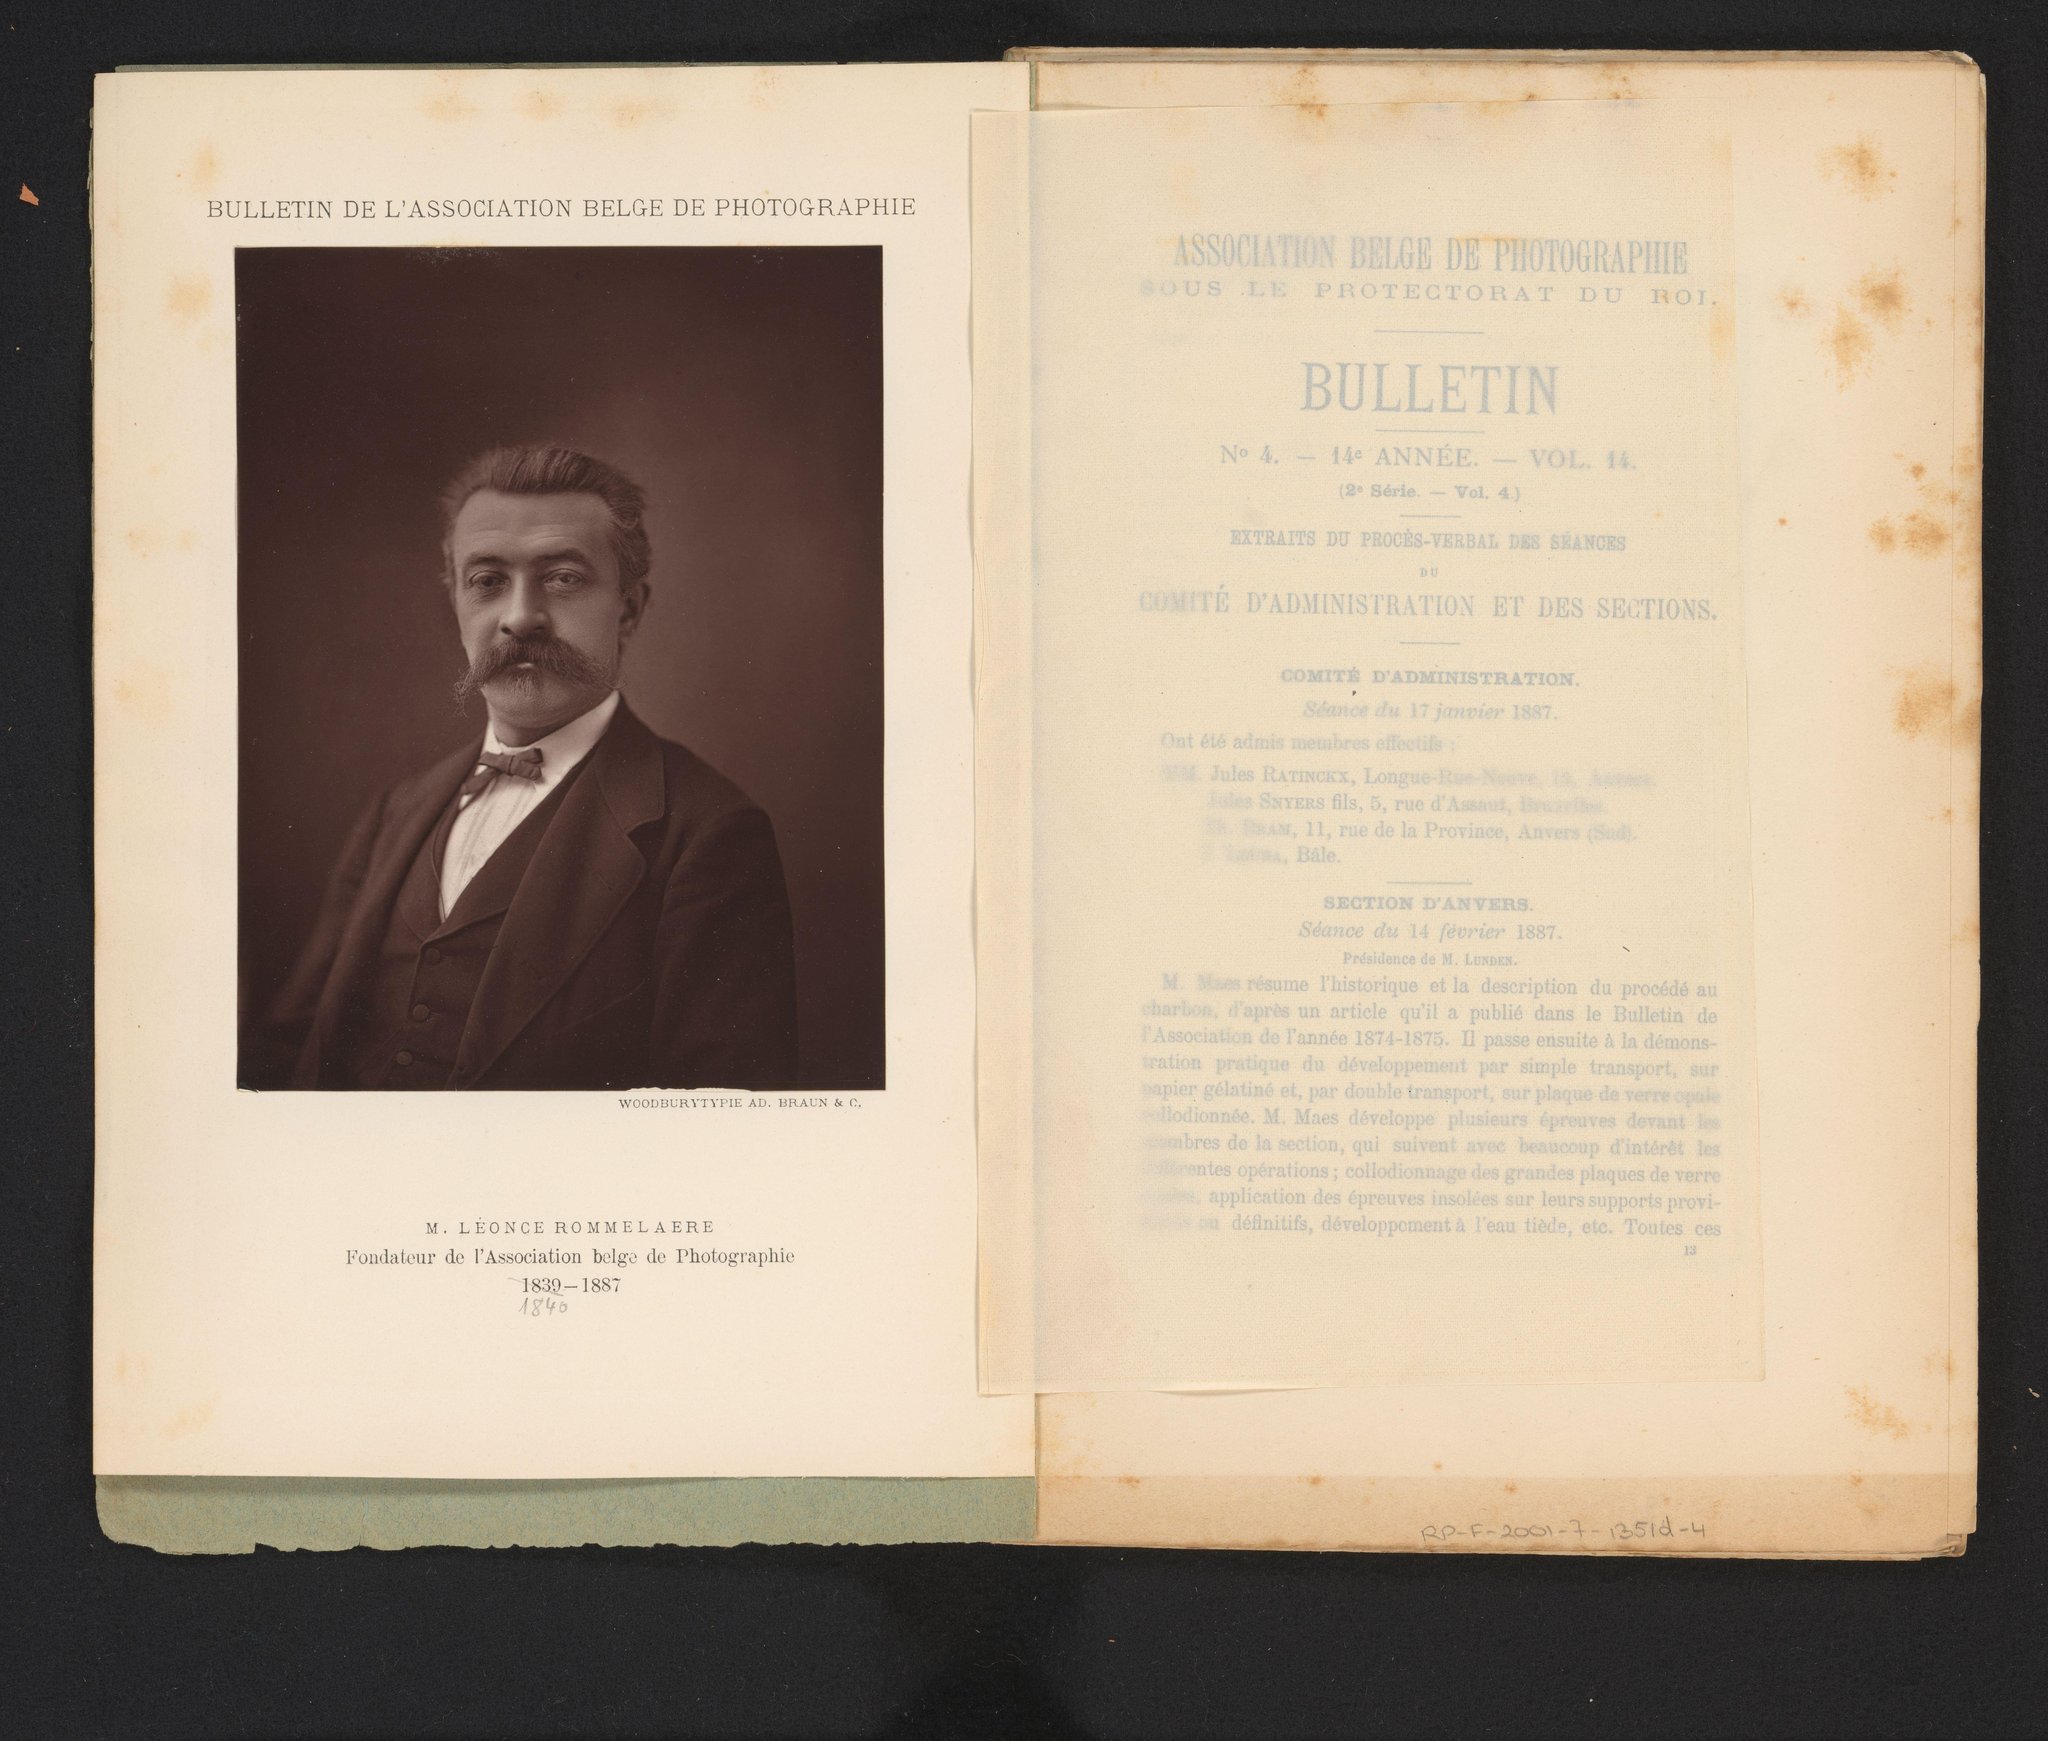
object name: page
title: M. Léonce Rommelaere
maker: Anonymous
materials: paper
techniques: woodburytype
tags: ghent, brussels, léonce rommelaere, historical persons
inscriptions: inscription: ‘Fondateur de l'Association belge de Photographie/ 1839-1887’, inscription: ‘BULLETIN DE L'ASSOCIATION BELGE DE PHOTOGRAPHIE’